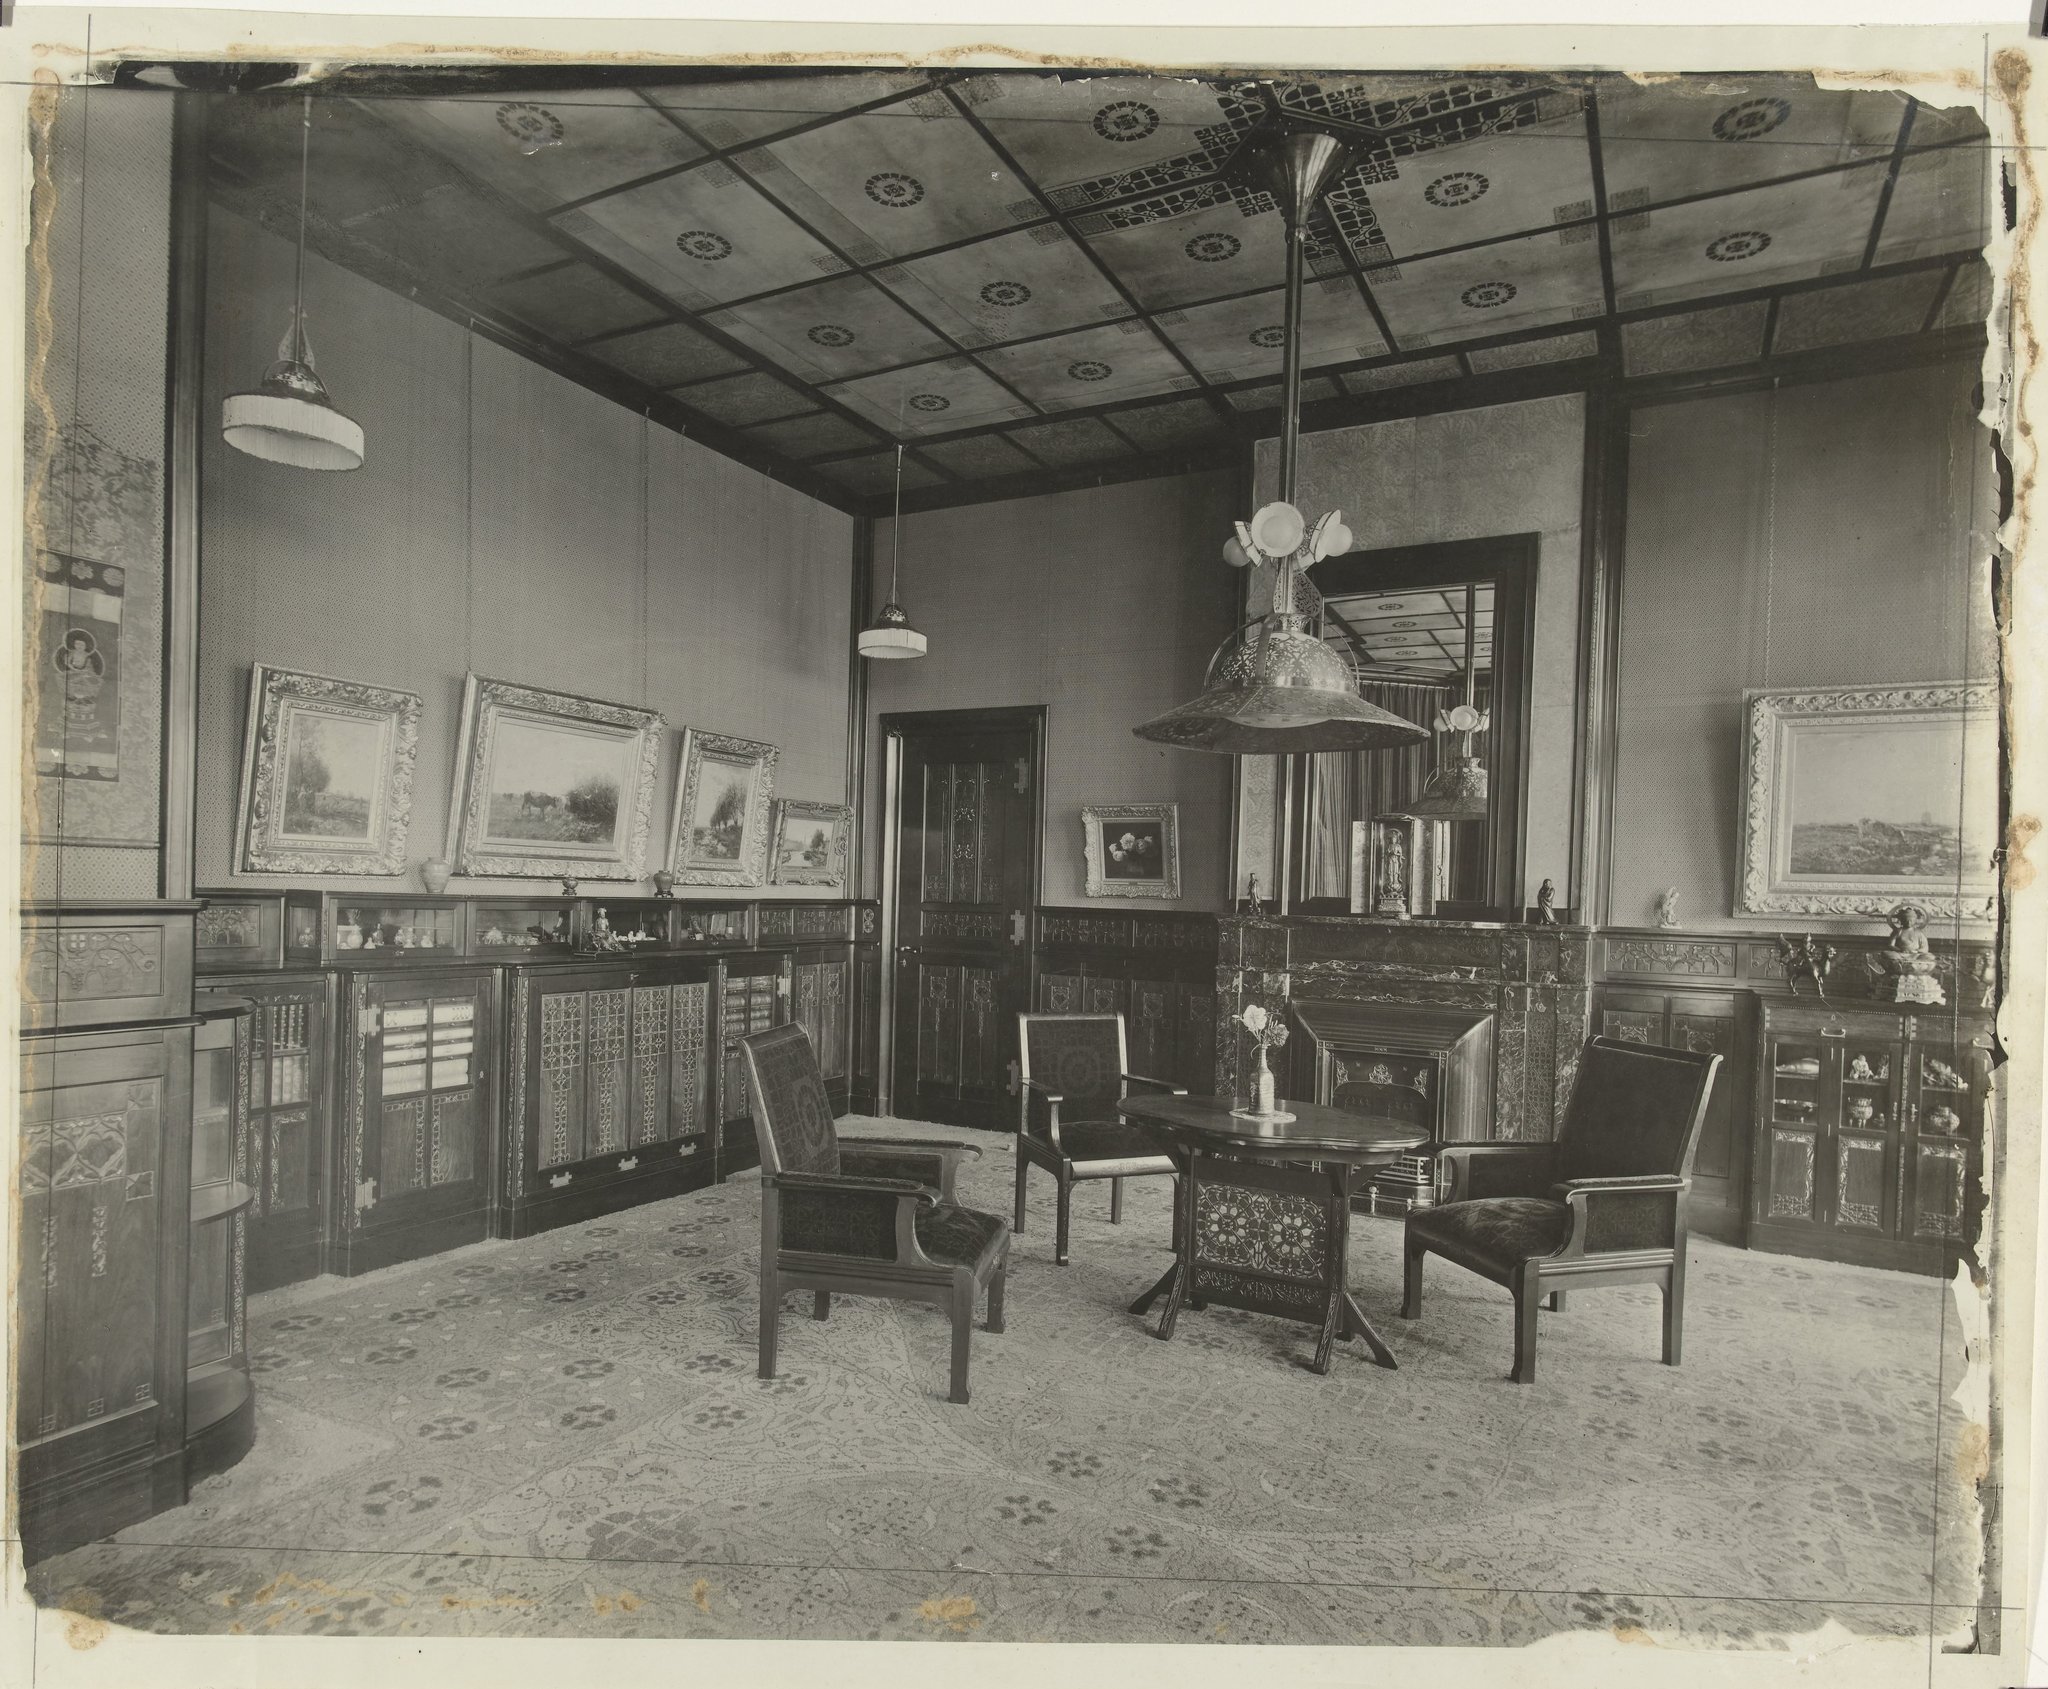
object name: photograph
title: Interieur van het huis van E.R. Harkema te Amsterdam of Laren, ontworpen door Theo Nieuwenhuis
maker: august frederik willem vogt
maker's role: fotograaf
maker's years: 1871-1922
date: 1897-1905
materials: cardboard, photographic support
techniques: gelatin silver print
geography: netherlands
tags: print maker, draughtsman, theo nieuwenhuis, decorations (interior of the house), furniture and household effects, amsterdam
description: Interieur van het huis van E.R. Harkema te Amsterdam of Laren, ontworpen door Theo Nieuwenhuis in de werkplaats van E.J. van Wisselingh & Co., Amsterdam. Op de foto is met lijnen in potlood een kleiner kader aangeduid